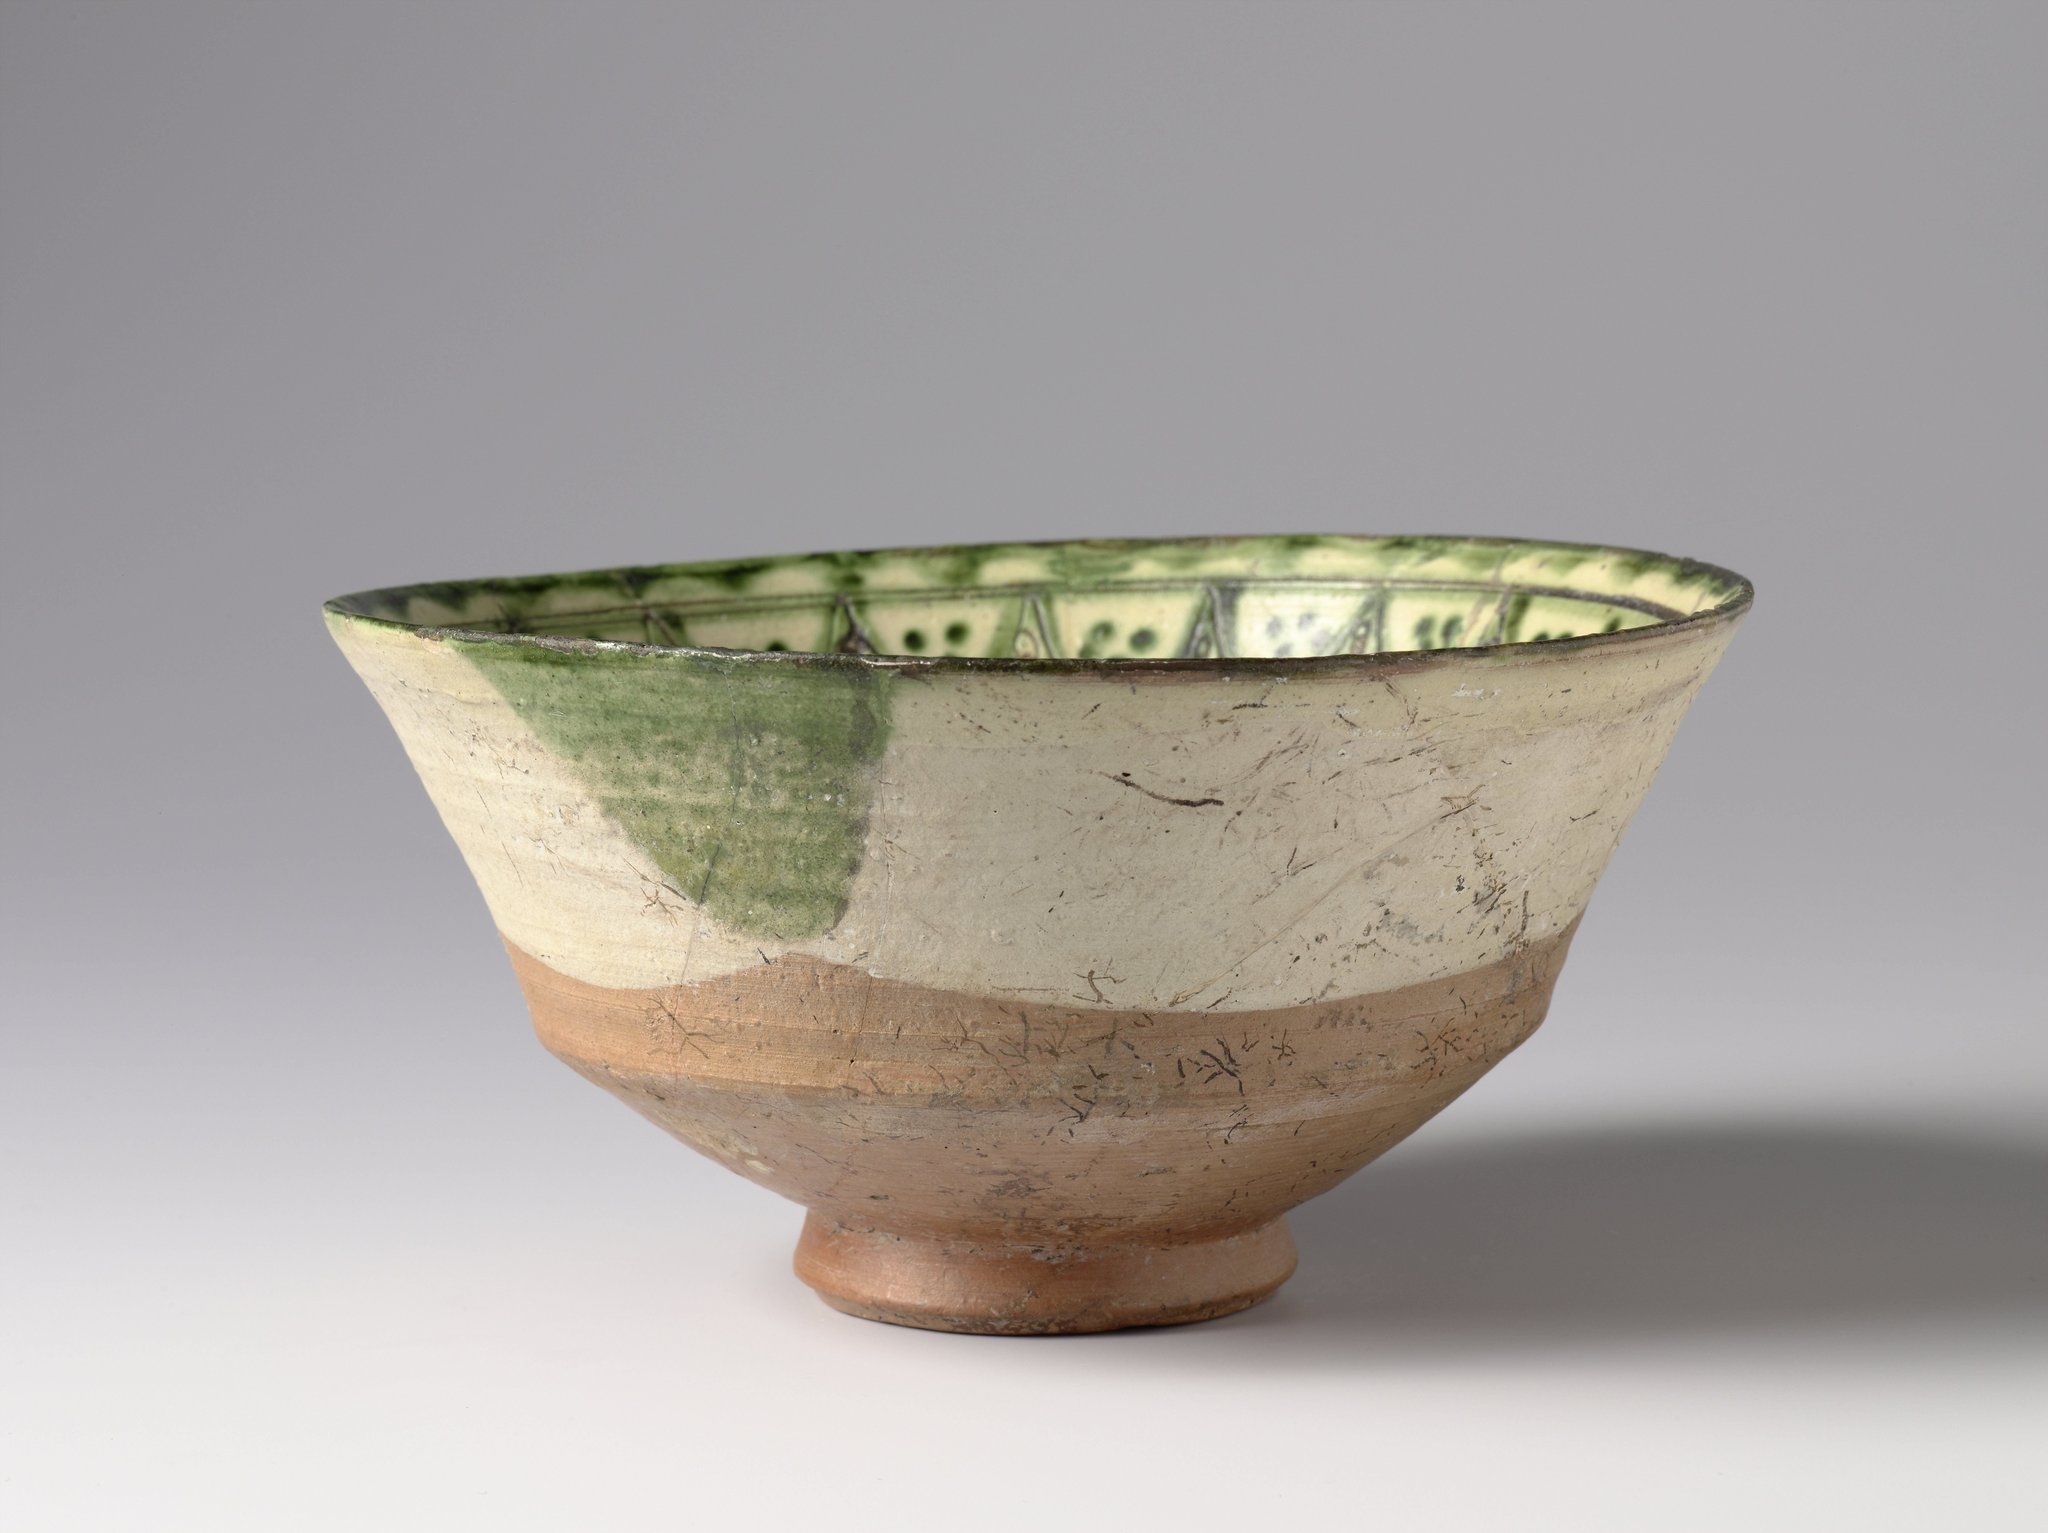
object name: bowl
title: Bowl with diaper and scroll patterns in green on a white slip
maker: Anonymous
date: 1000-1199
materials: earthenware, glaze, paint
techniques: firing, turning, vitrification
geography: amol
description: Kom van aardewerk gedecoreerd met sgraffito krulwerk op engobe van witte slib waarop servetwerk en stippen in een monochrome groene loodglazuur is aangebracht.